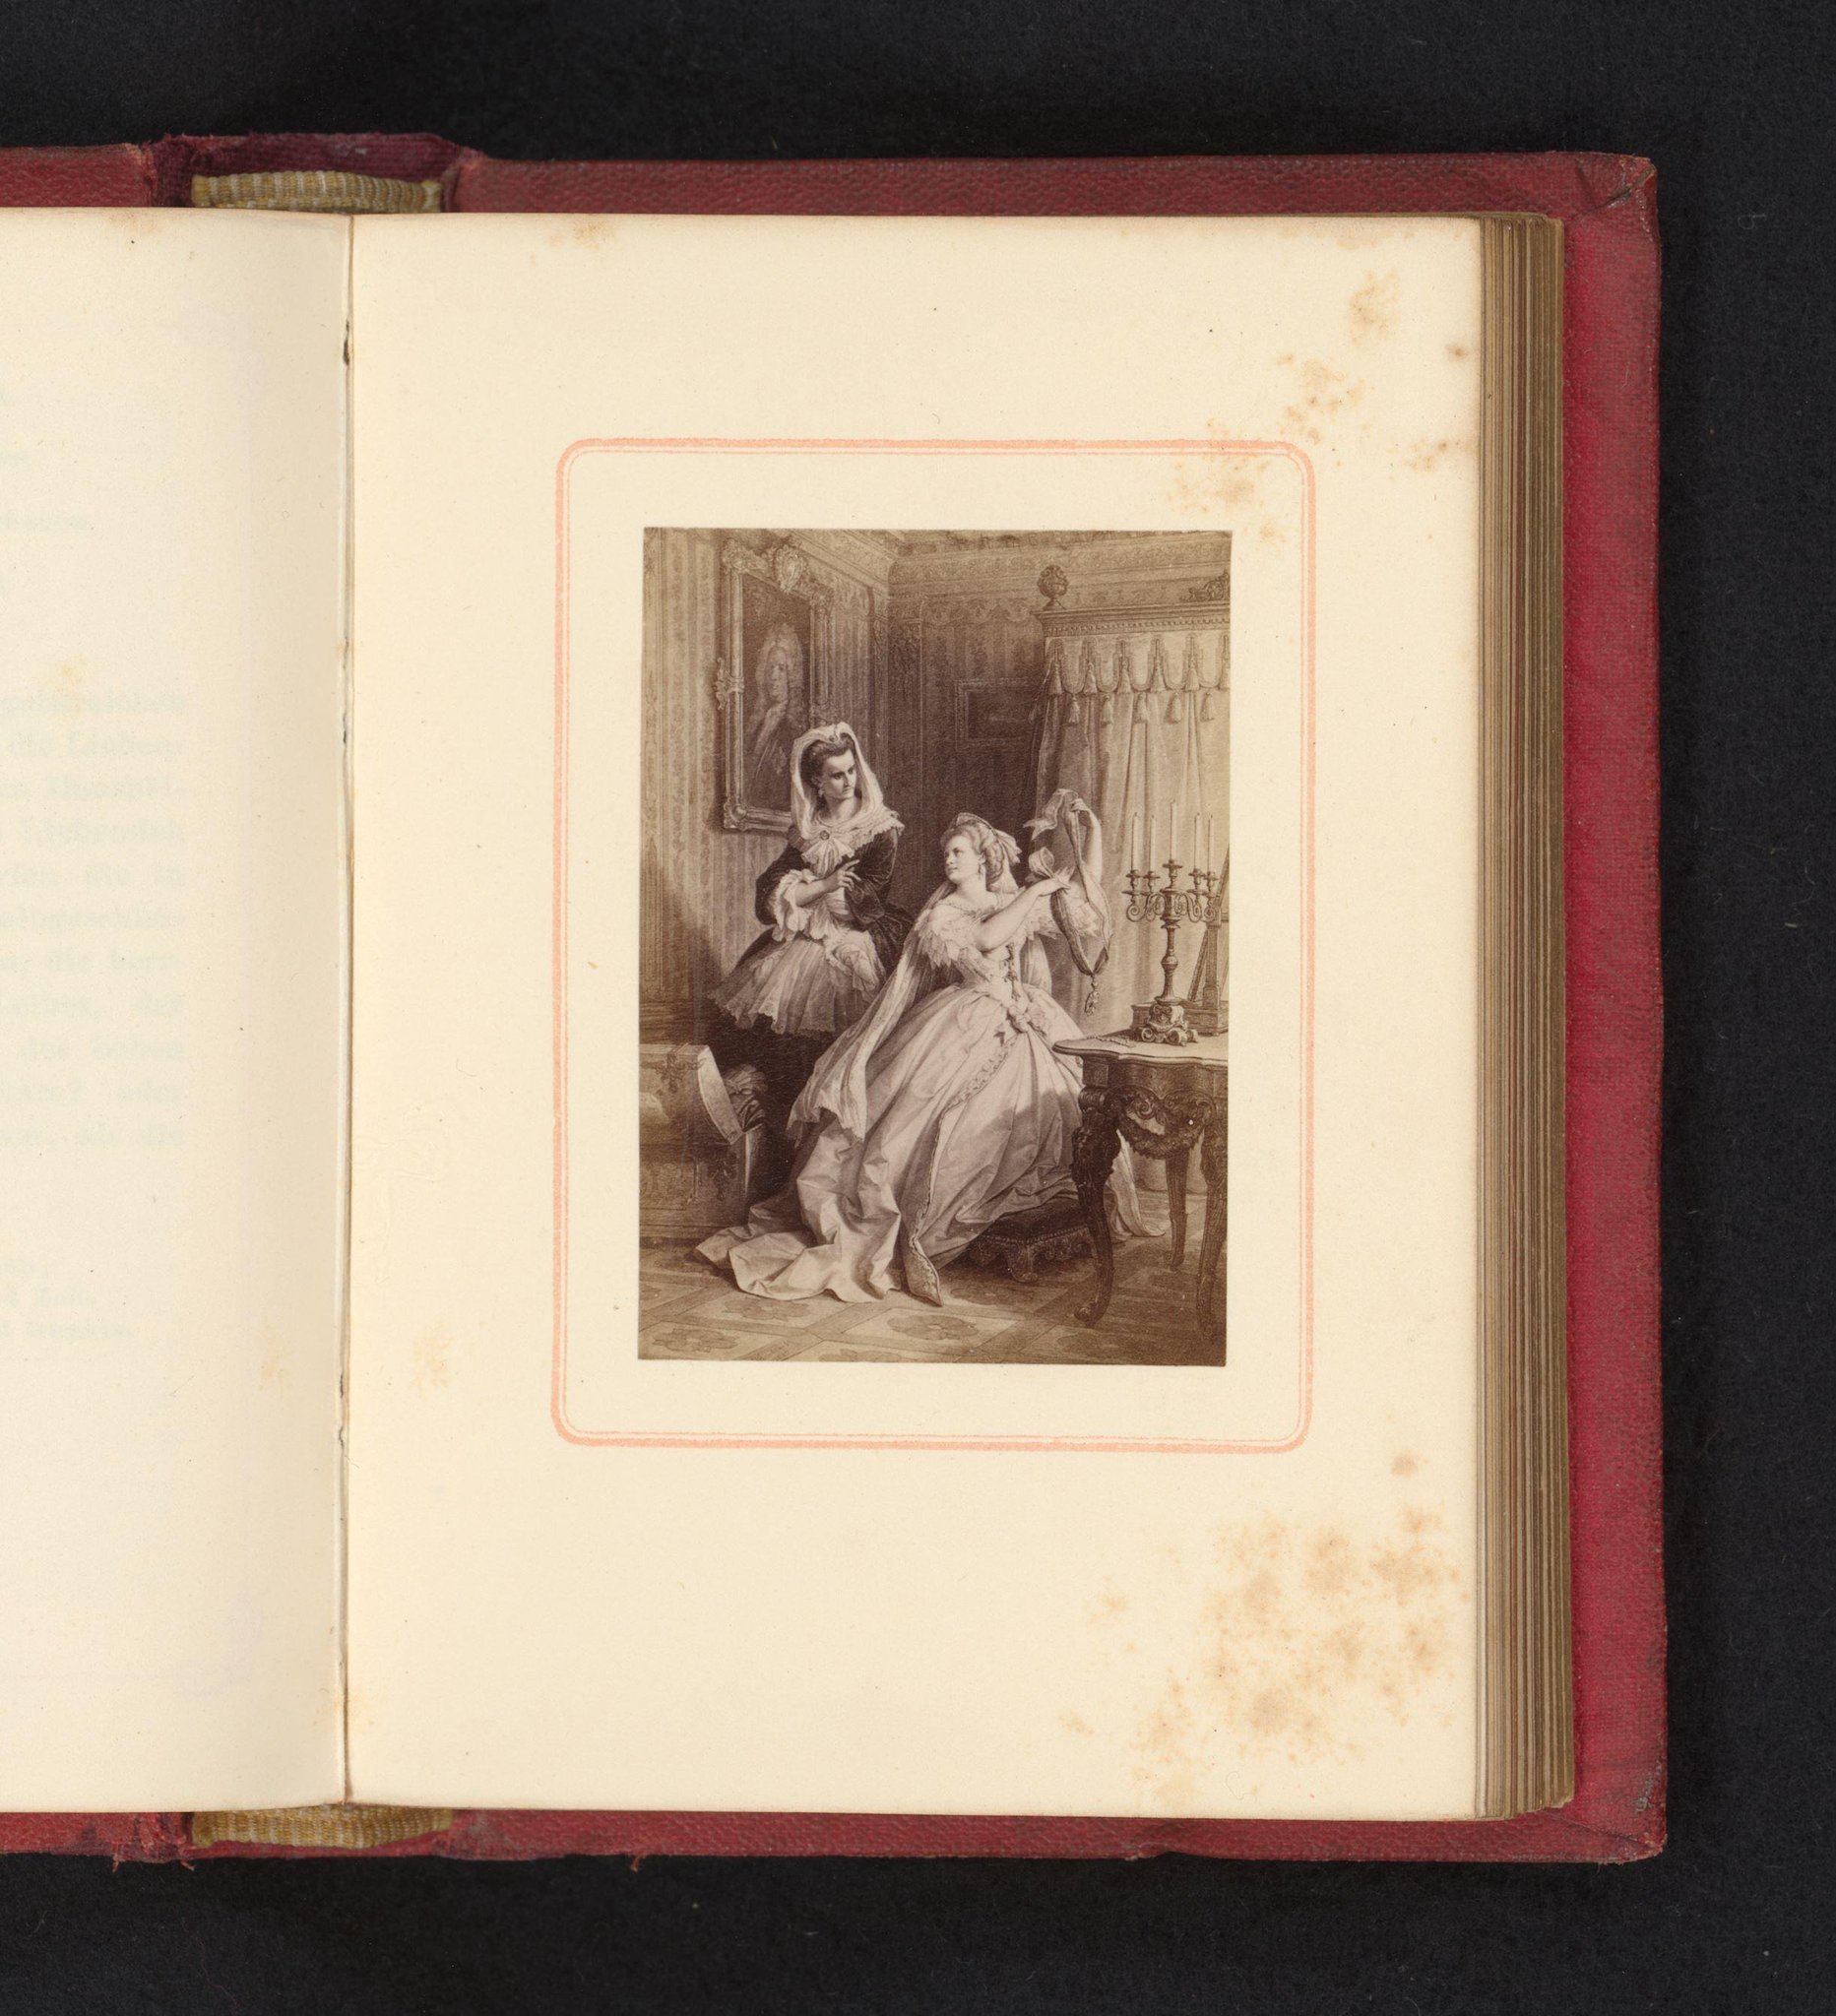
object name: photograph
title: Fotoreproductie van de tekening Eugenie, Natürliche Tochter door Wilhelm von Kaulbach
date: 1863-1864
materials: paper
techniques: albumen print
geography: munich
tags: drawing, sketch, female literary characters